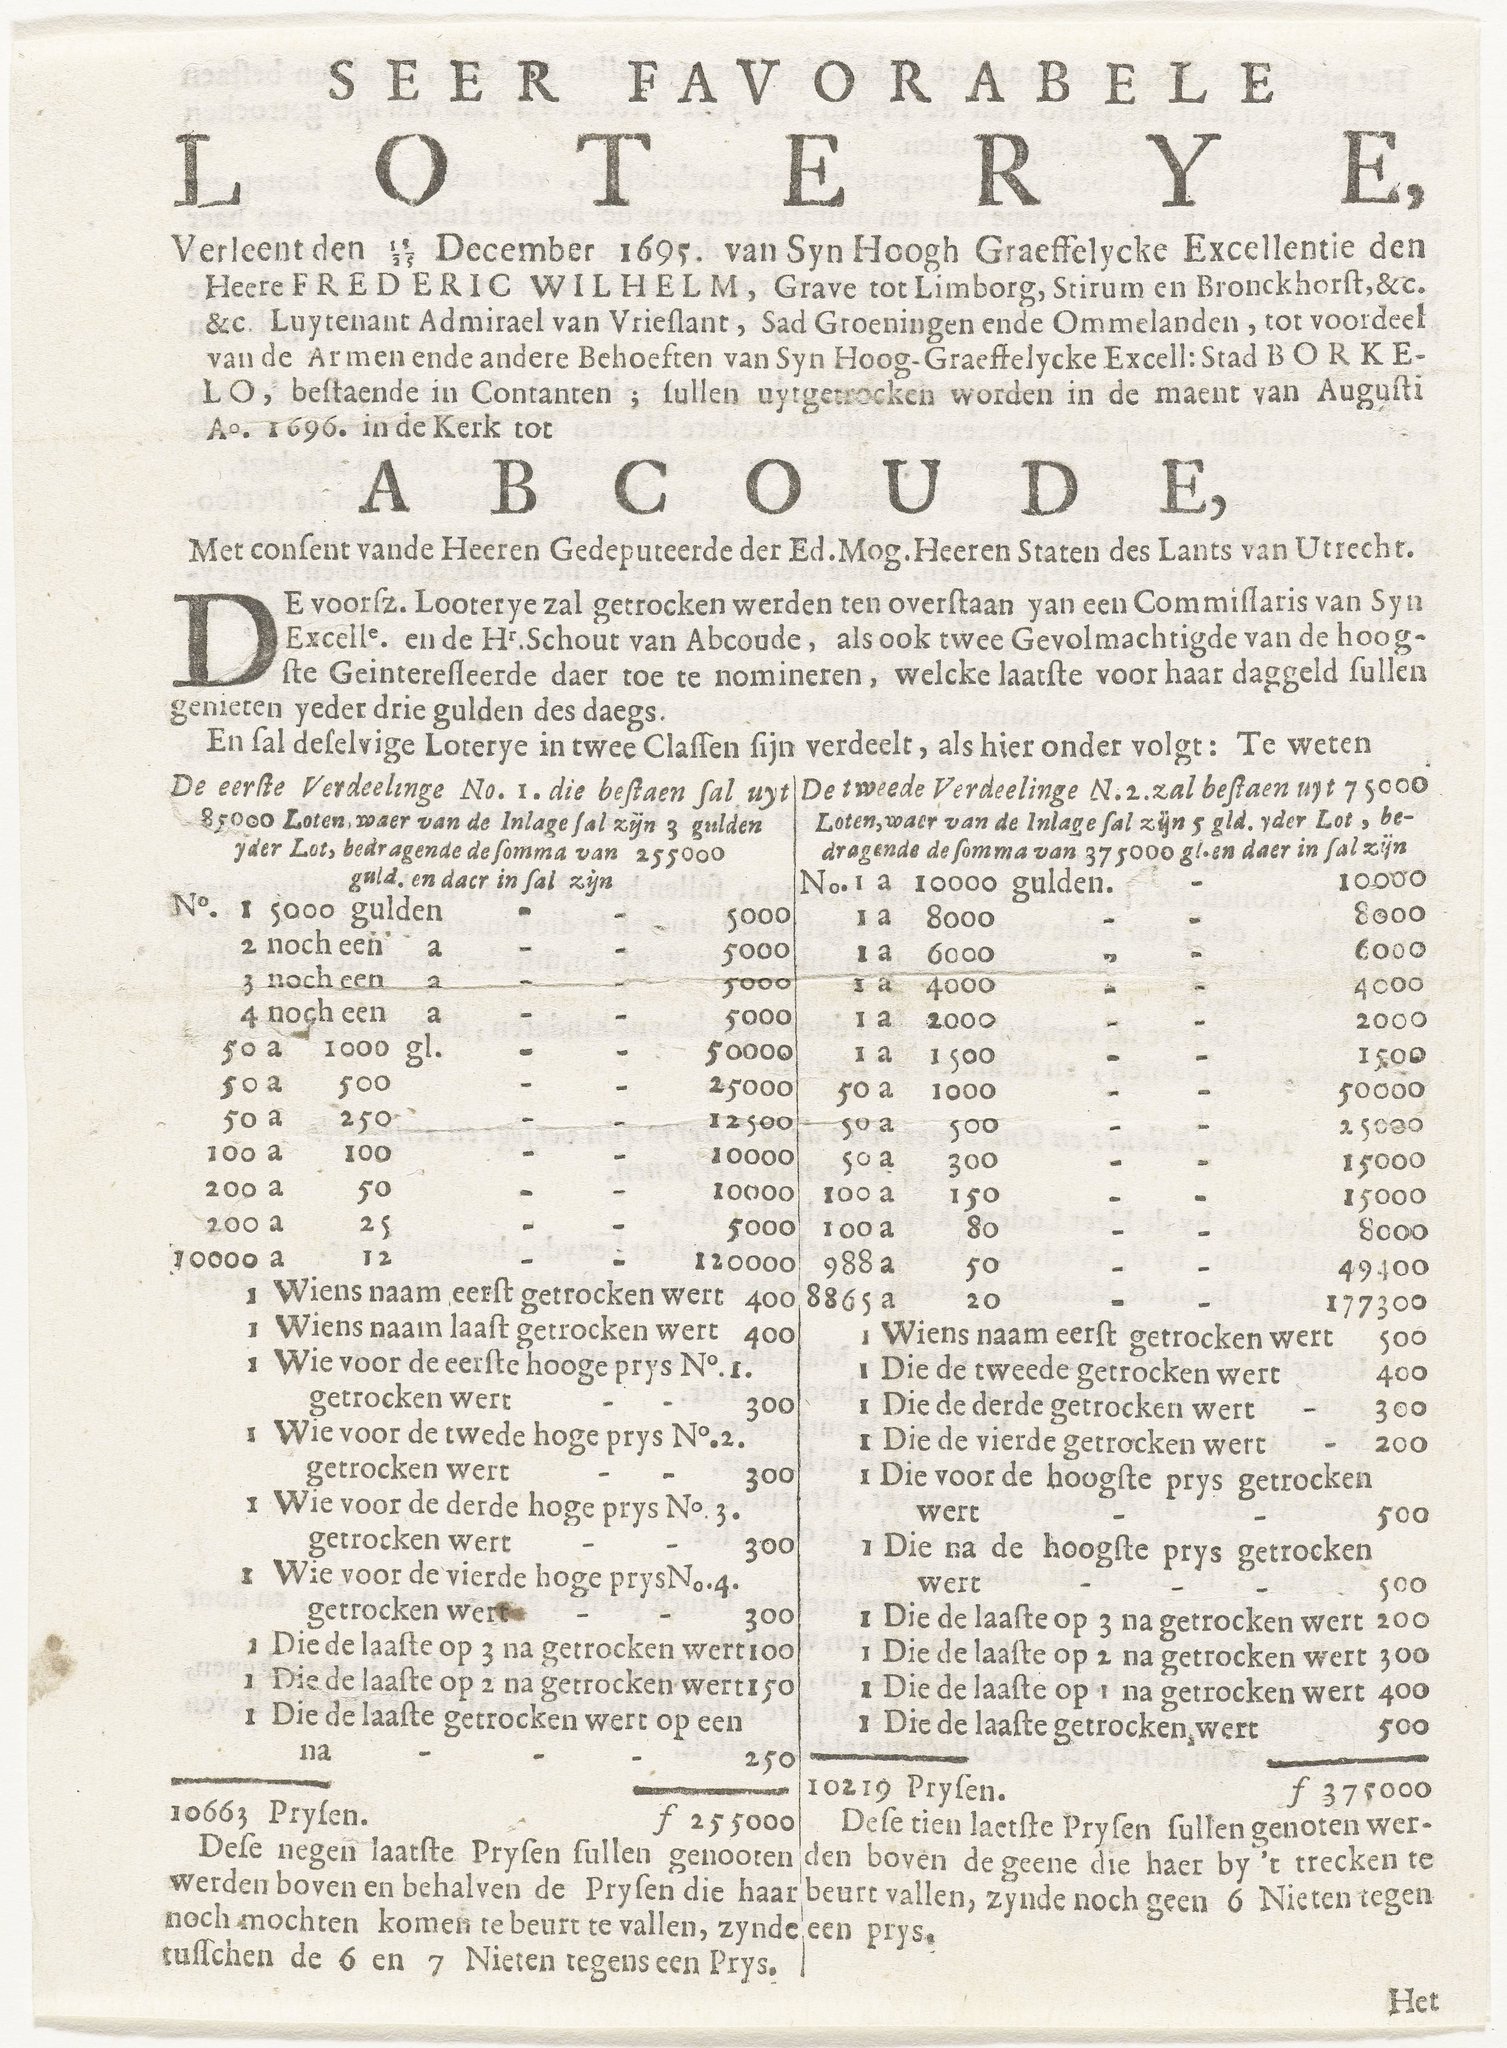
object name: loterijbrief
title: Aankondiging van een loterij te Abcoude, 1696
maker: Anonymous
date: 1695-1696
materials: paper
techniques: letterpress printing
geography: northern netherlands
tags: abcoude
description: Tekstblad met aankondiging van de loterij te houden in augustus 1696 in de kerk te Abcoude. Met de verlening van toestemming voor de loterij gegeven op 25 december 1695 door Frederik Willem van Limburg en Bronckhorst, ten bate van de armen van Borculo. Met op de voorzijde een lijst van de te winnen prijzen, op de achterzijde de artikelen en voorwaarden.